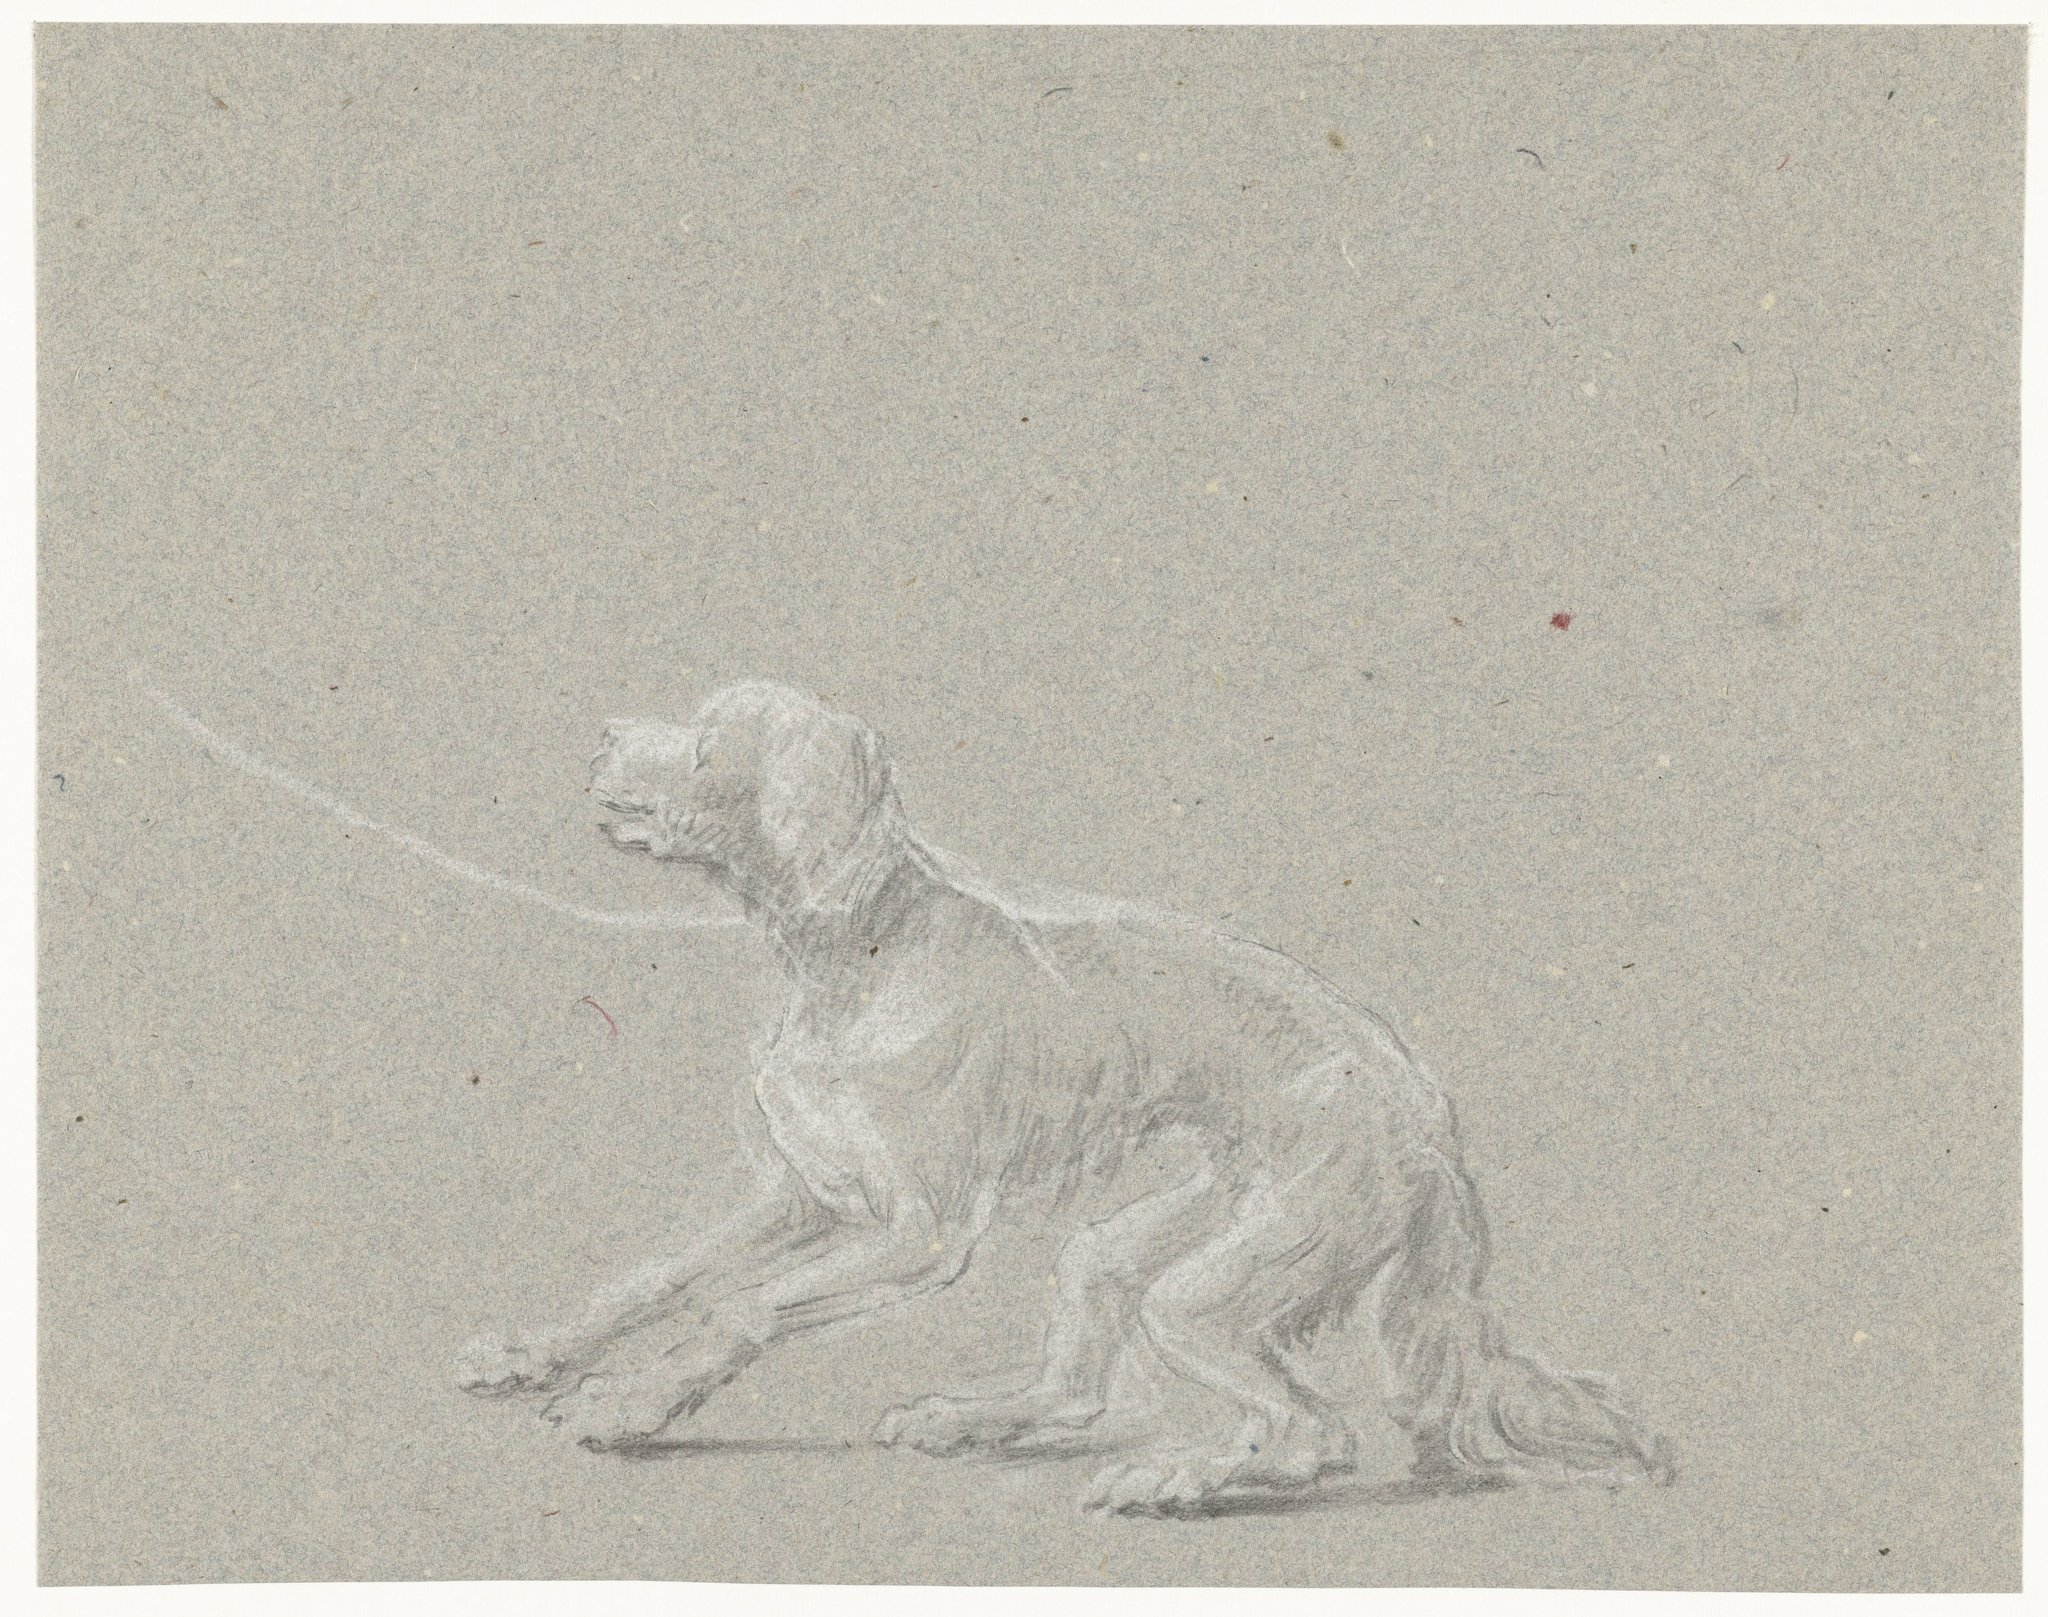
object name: drawing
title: Hond aan een riem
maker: louis moritz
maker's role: draughtsman, painter, print maker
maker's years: 1773-1850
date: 1783-1850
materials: chalk, paper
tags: dog